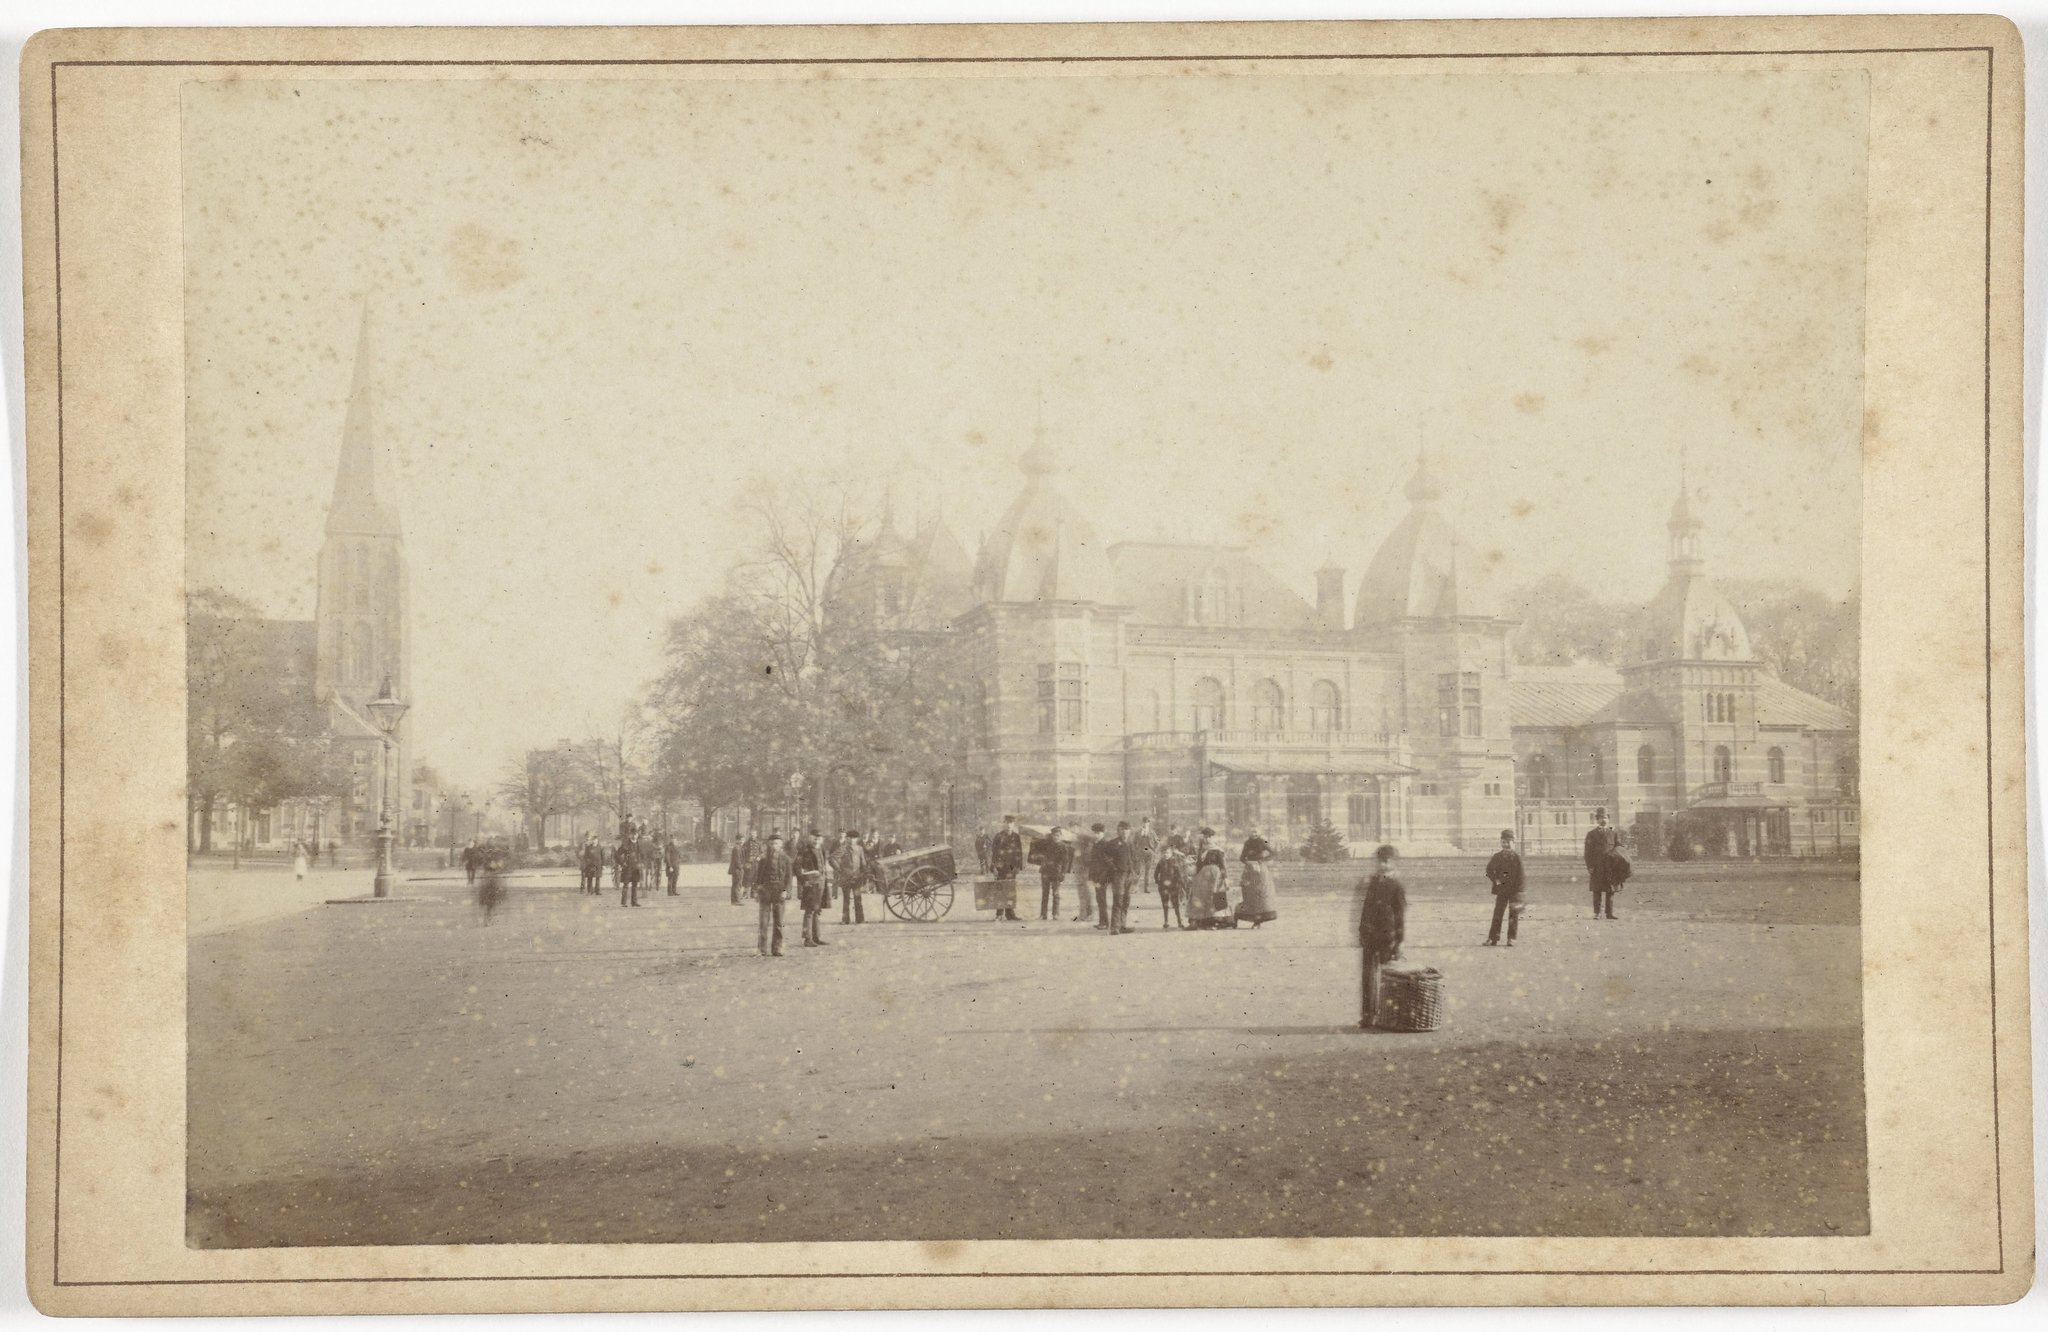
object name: photograph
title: Velperplein met Musis Sacrum, de schouwburg te Arnhem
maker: j.s.j. de jongh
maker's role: fotograaf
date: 1860-1890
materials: cardboard, paper, photographic support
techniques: albumen print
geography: arnhem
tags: square, place, circus, etc., arnhem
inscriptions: signature: ‘J.S.J. de Jongh, Koningstraat 85 Arnhem’, name: ‘Vosmaer’, annotation: ‘Velperplein. Musis Sacrum. Arnhem.’